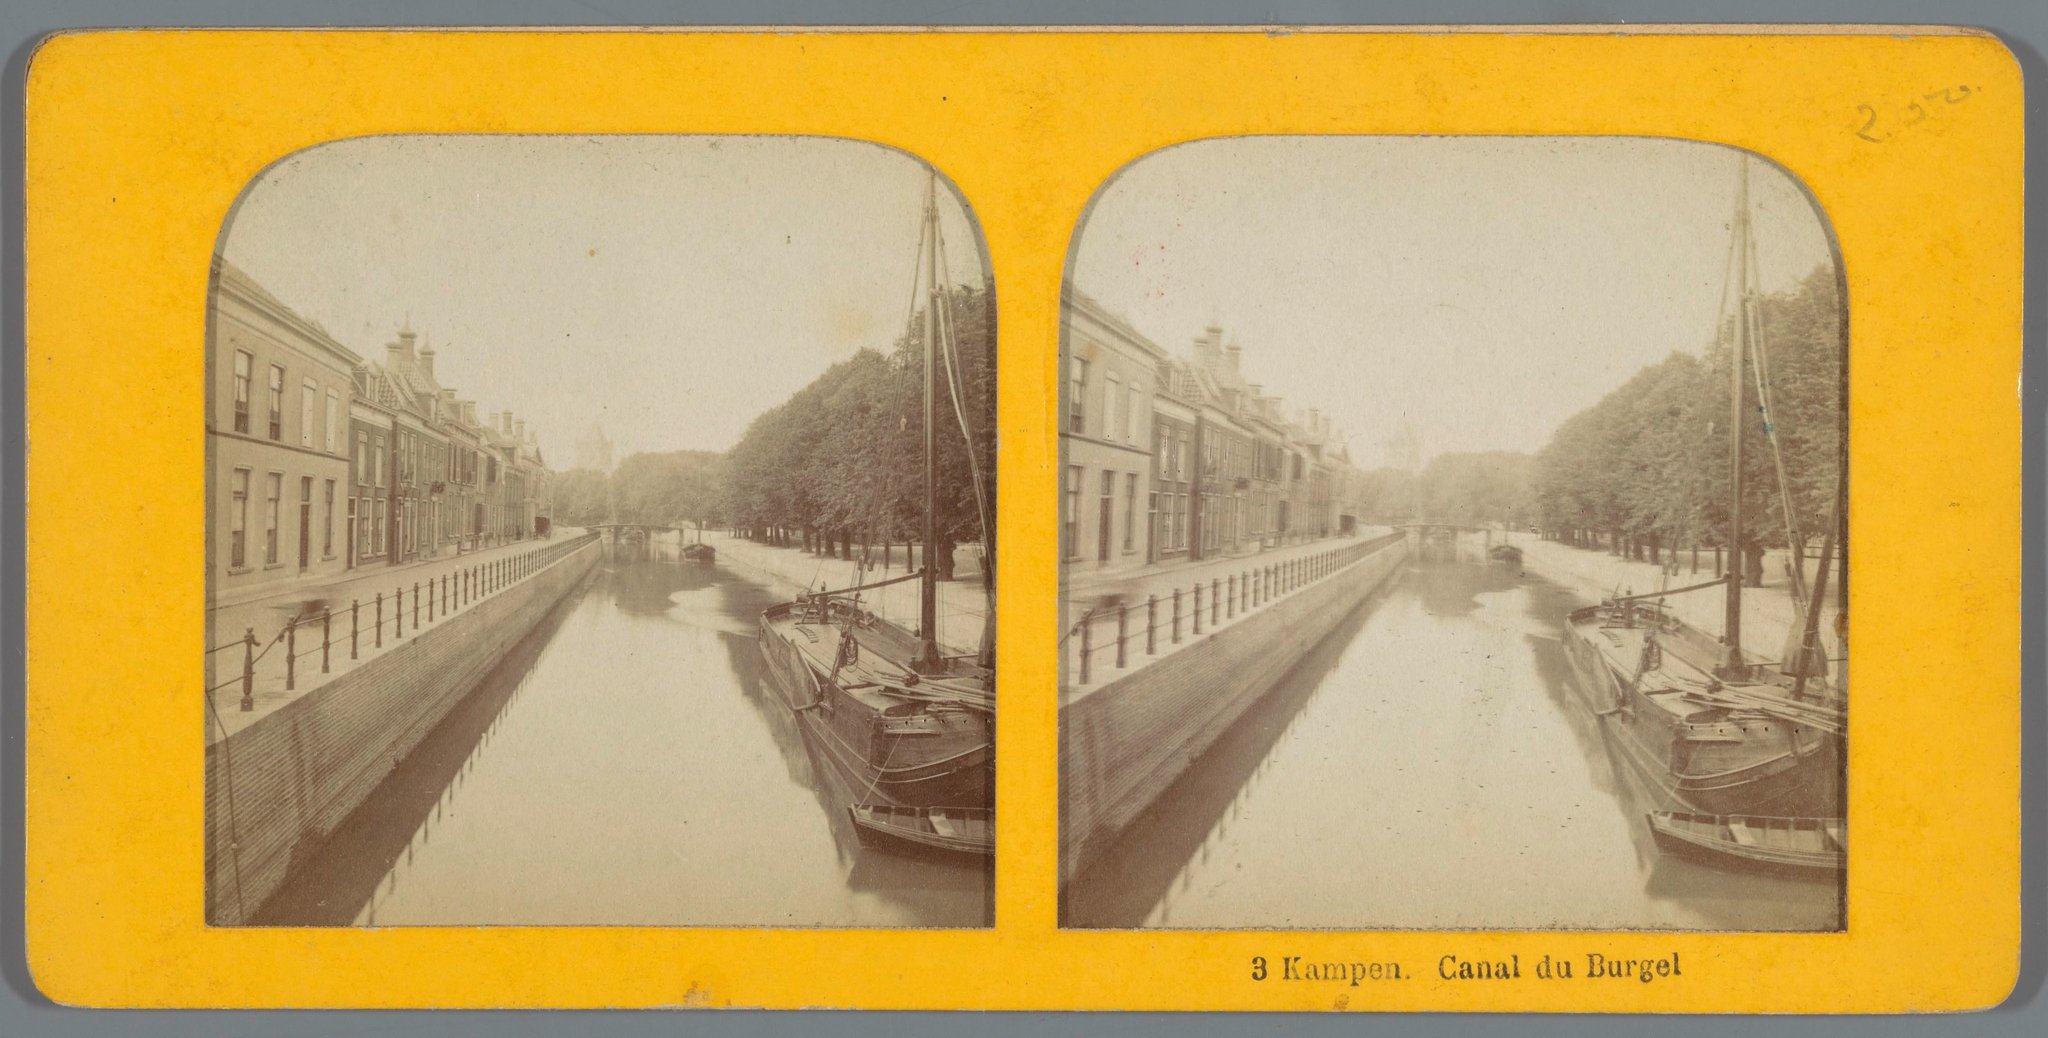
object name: tissue stereograph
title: Kampen. Canal du Burgel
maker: Anonymous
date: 1855-1875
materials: cardboard, paper, photographic support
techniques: albumen print, cutting, hand coloring, perforating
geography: kampen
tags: canals, waters (in city)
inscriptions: number: ‘3’, number: ‘9’